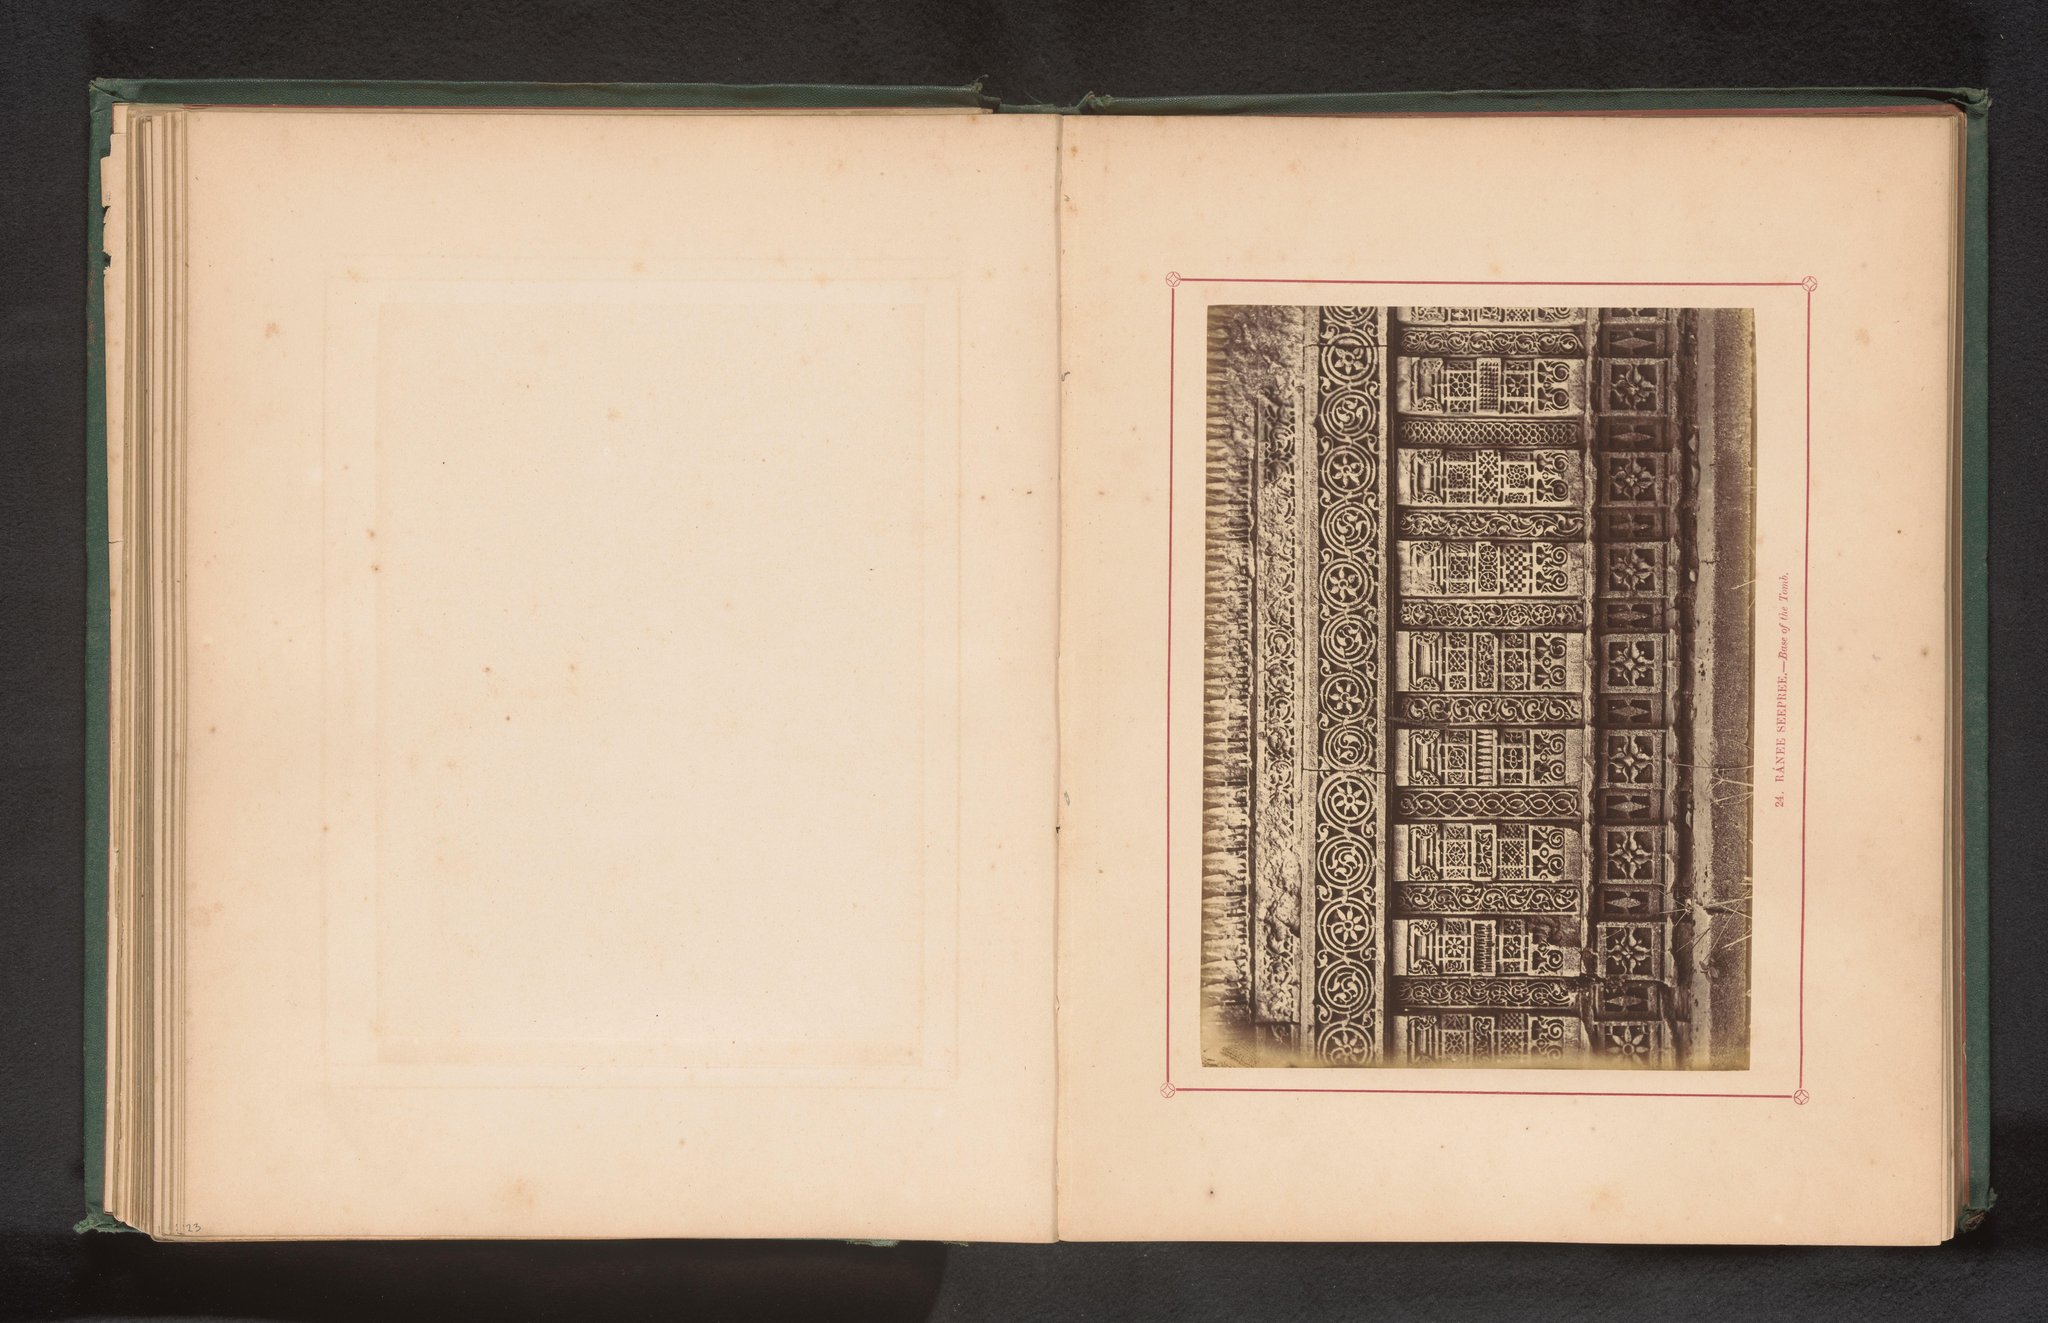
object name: page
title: Decoraties op een tombe bij de Rani Sipri's-moskee in Ahmedabad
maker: thomas biggs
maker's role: fotograaf, kapitein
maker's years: 1822-1905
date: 1856-1866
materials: photographic support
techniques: albumen print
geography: ahmedabad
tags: grave, tomb, temple, shrine ~ islam, mohammedanism, ornamenting, decorating ~ applied arts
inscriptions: number: ‘24.’